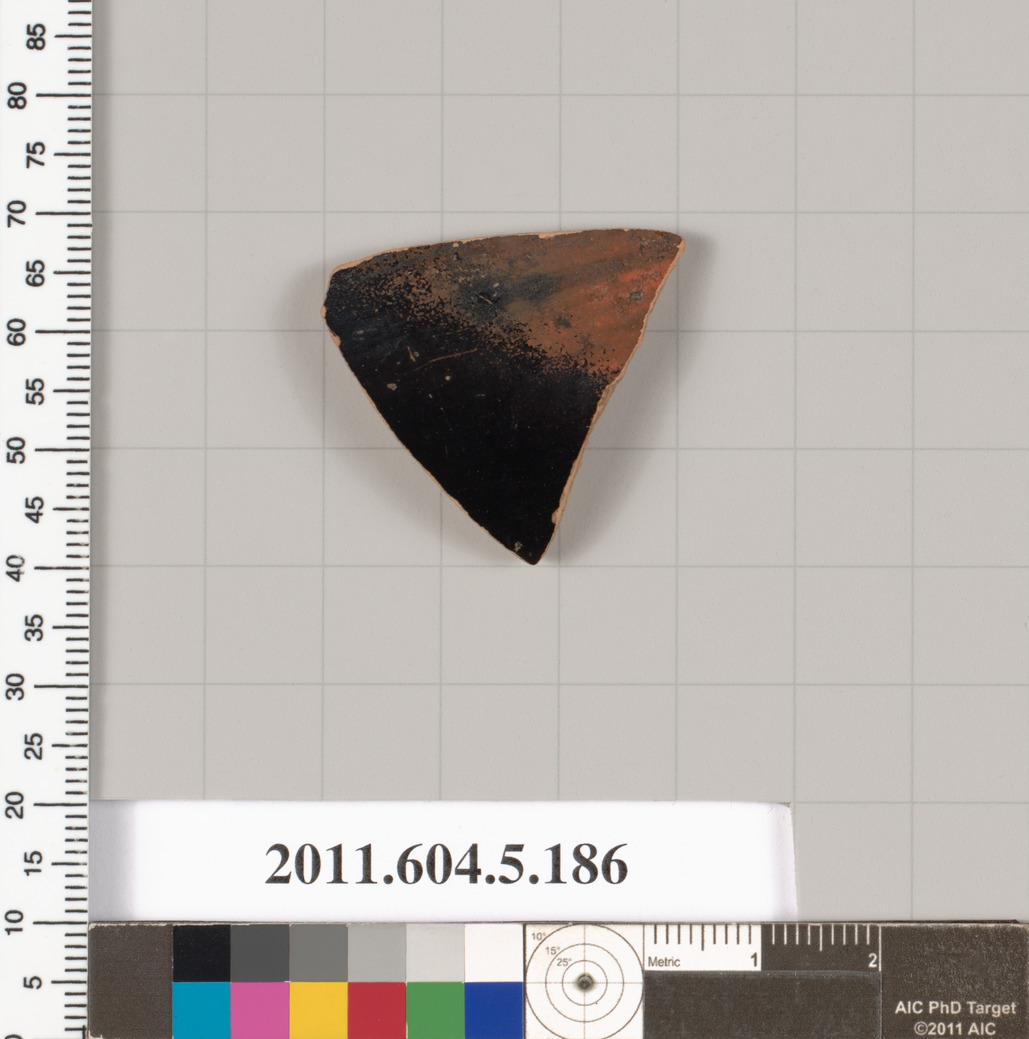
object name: kylix fragment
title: Terracotta fragment of a kylix (drinking cup)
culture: greek, attic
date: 600-401 BCE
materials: terracotta